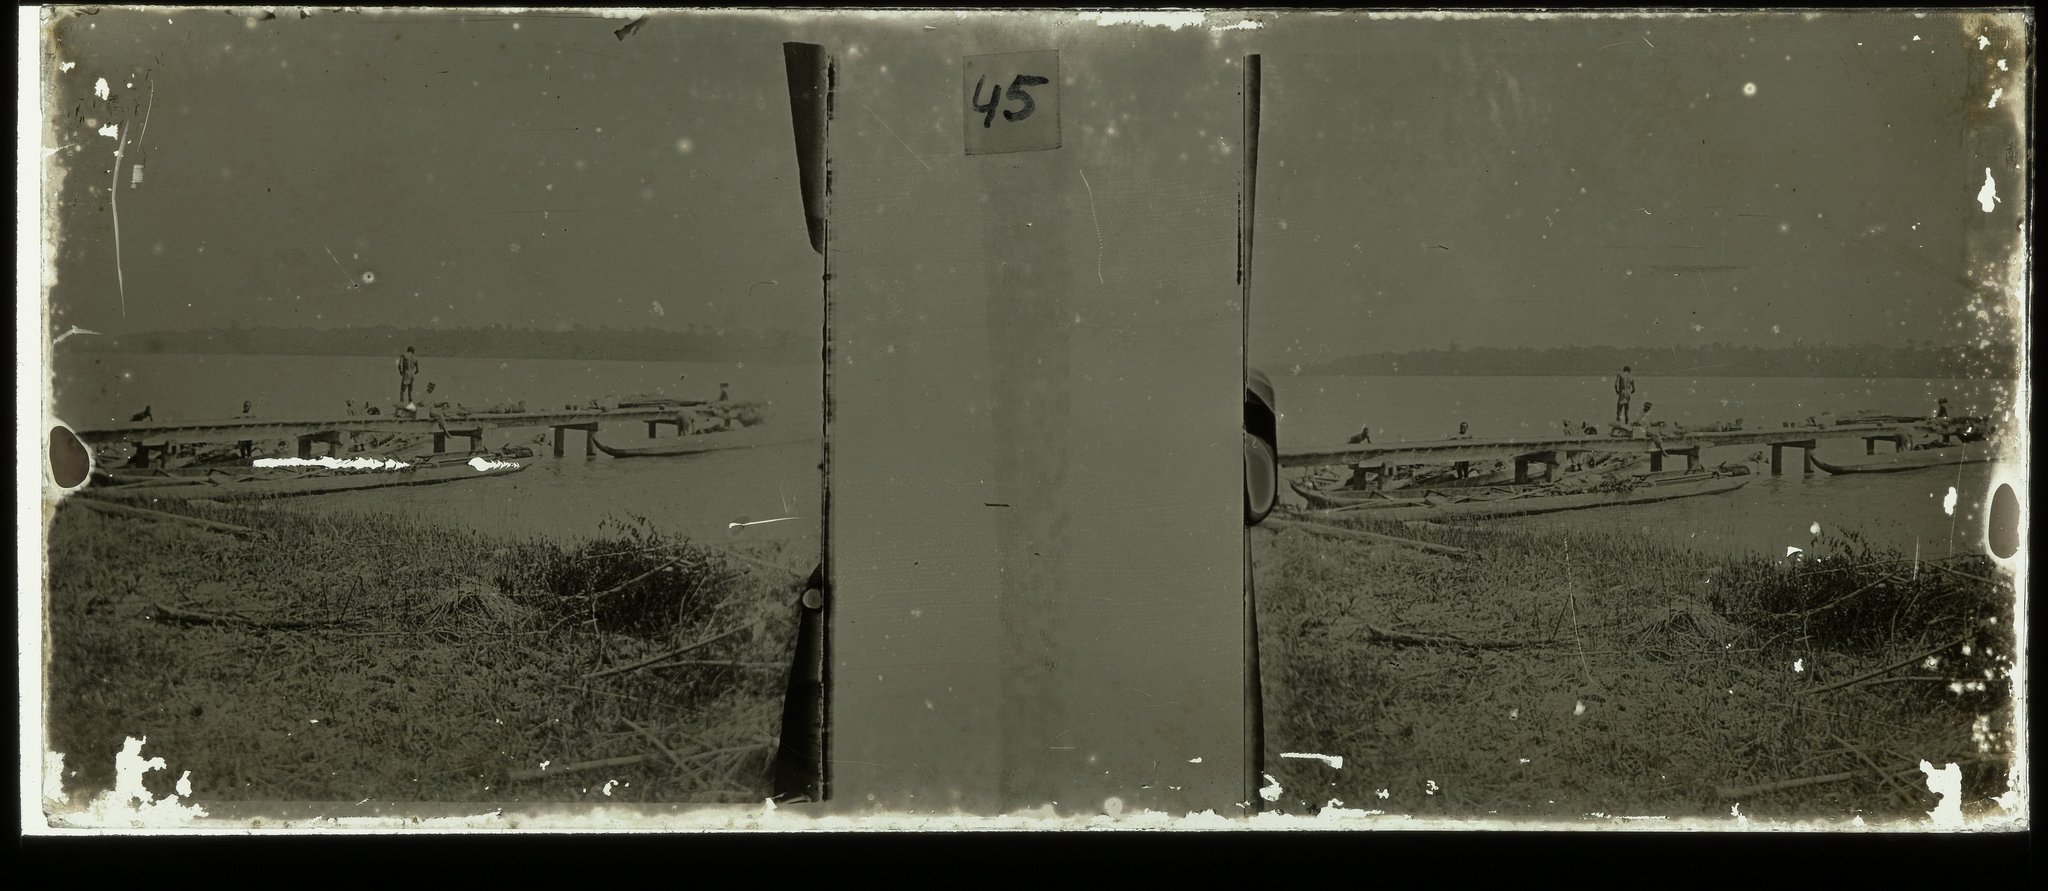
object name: stereograph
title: Steiger van plantage Accaribo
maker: theodoor brouwers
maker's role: amateurfotograaf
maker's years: 1874-1932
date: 1913-1930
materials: glass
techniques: photography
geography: suriname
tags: theodoor brouwers, plantation, suriname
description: In de periode 1911-1932 woonde op plantage Accaribo in Suriname de familie Brouwers van wie de foto's afkomstig zijn. Rond 1910 vond Theodoor Brouwers werk op plantage Accaribo. In 1929 werd hij eigenaar van de plantage. Op Accaribo werden in zijn tijd bananen geproduceerd en wat koffie.